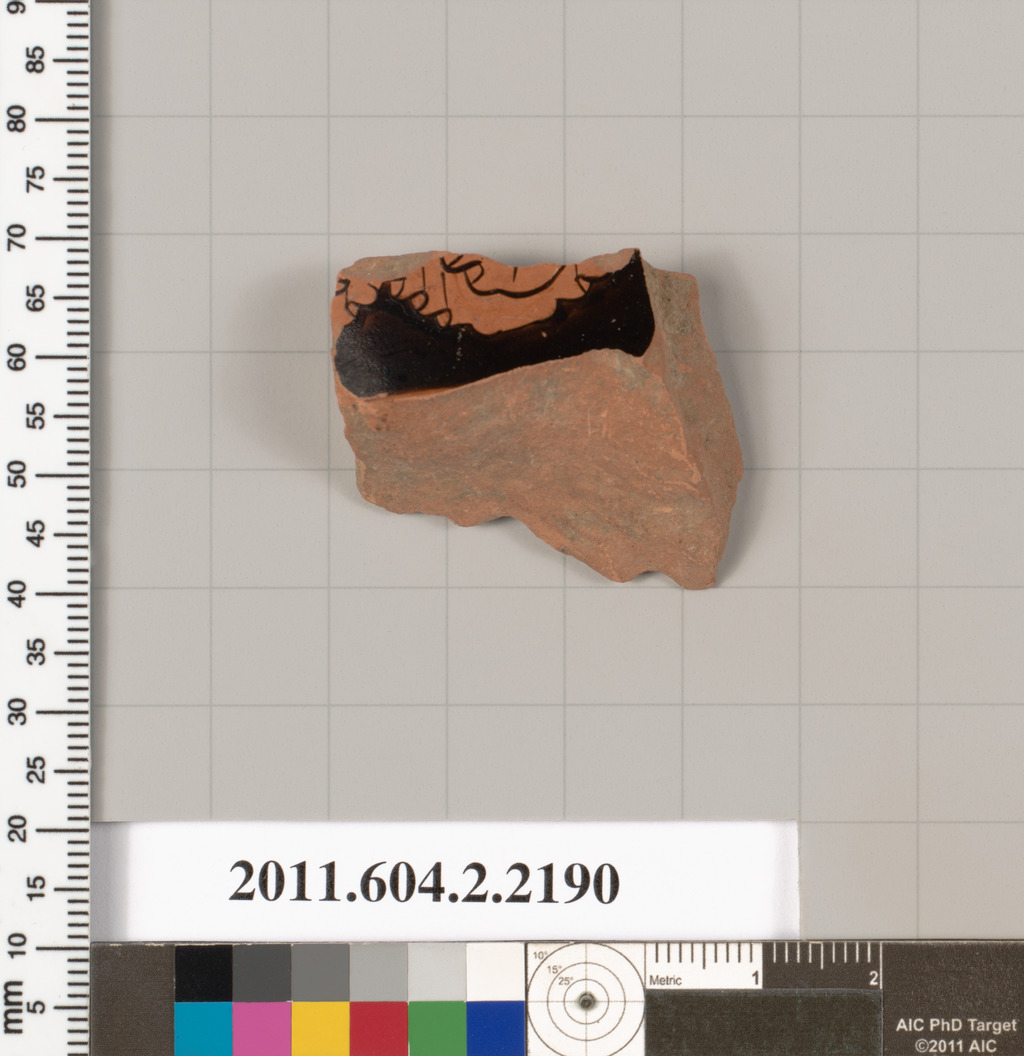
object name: pot fragment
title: Terracotta fragment of a pot; unglazed on the inside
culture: greek, attic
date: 490-480 BCE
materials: terracotta